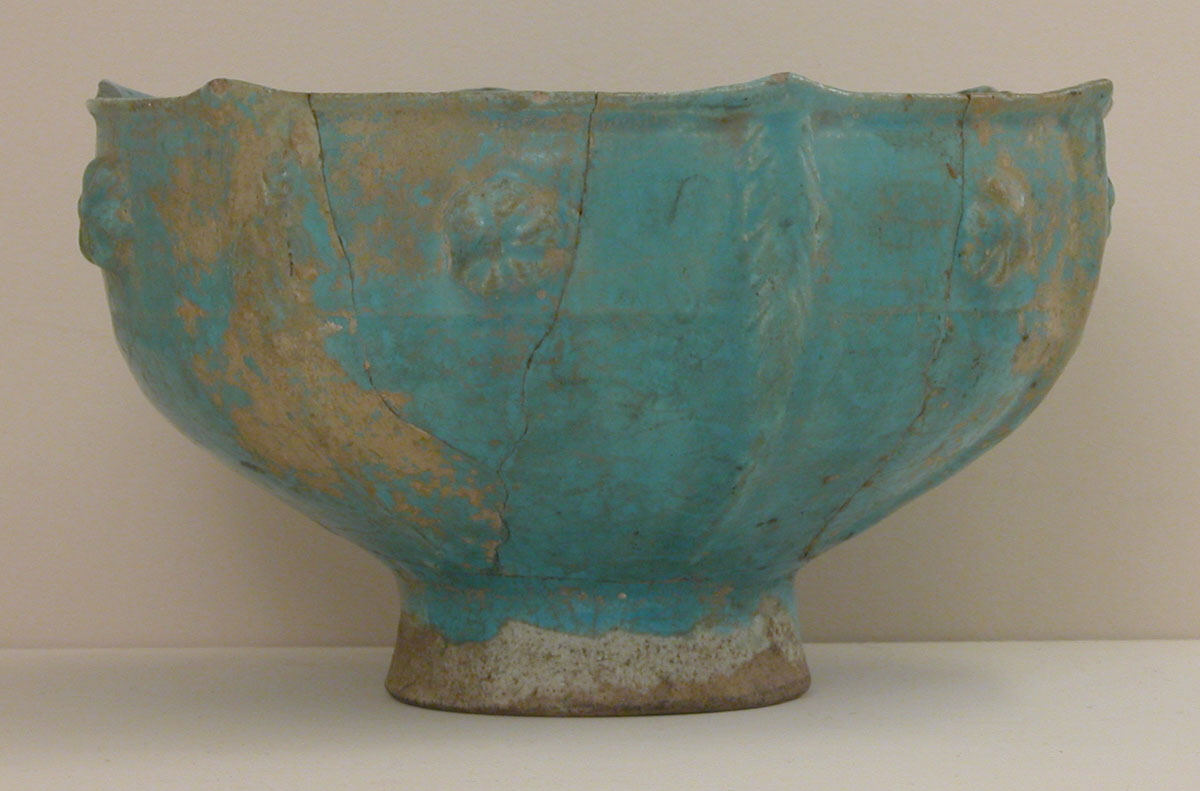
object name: bowl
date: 1101-1300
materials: stonepaste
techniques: glazing, molding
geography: iran